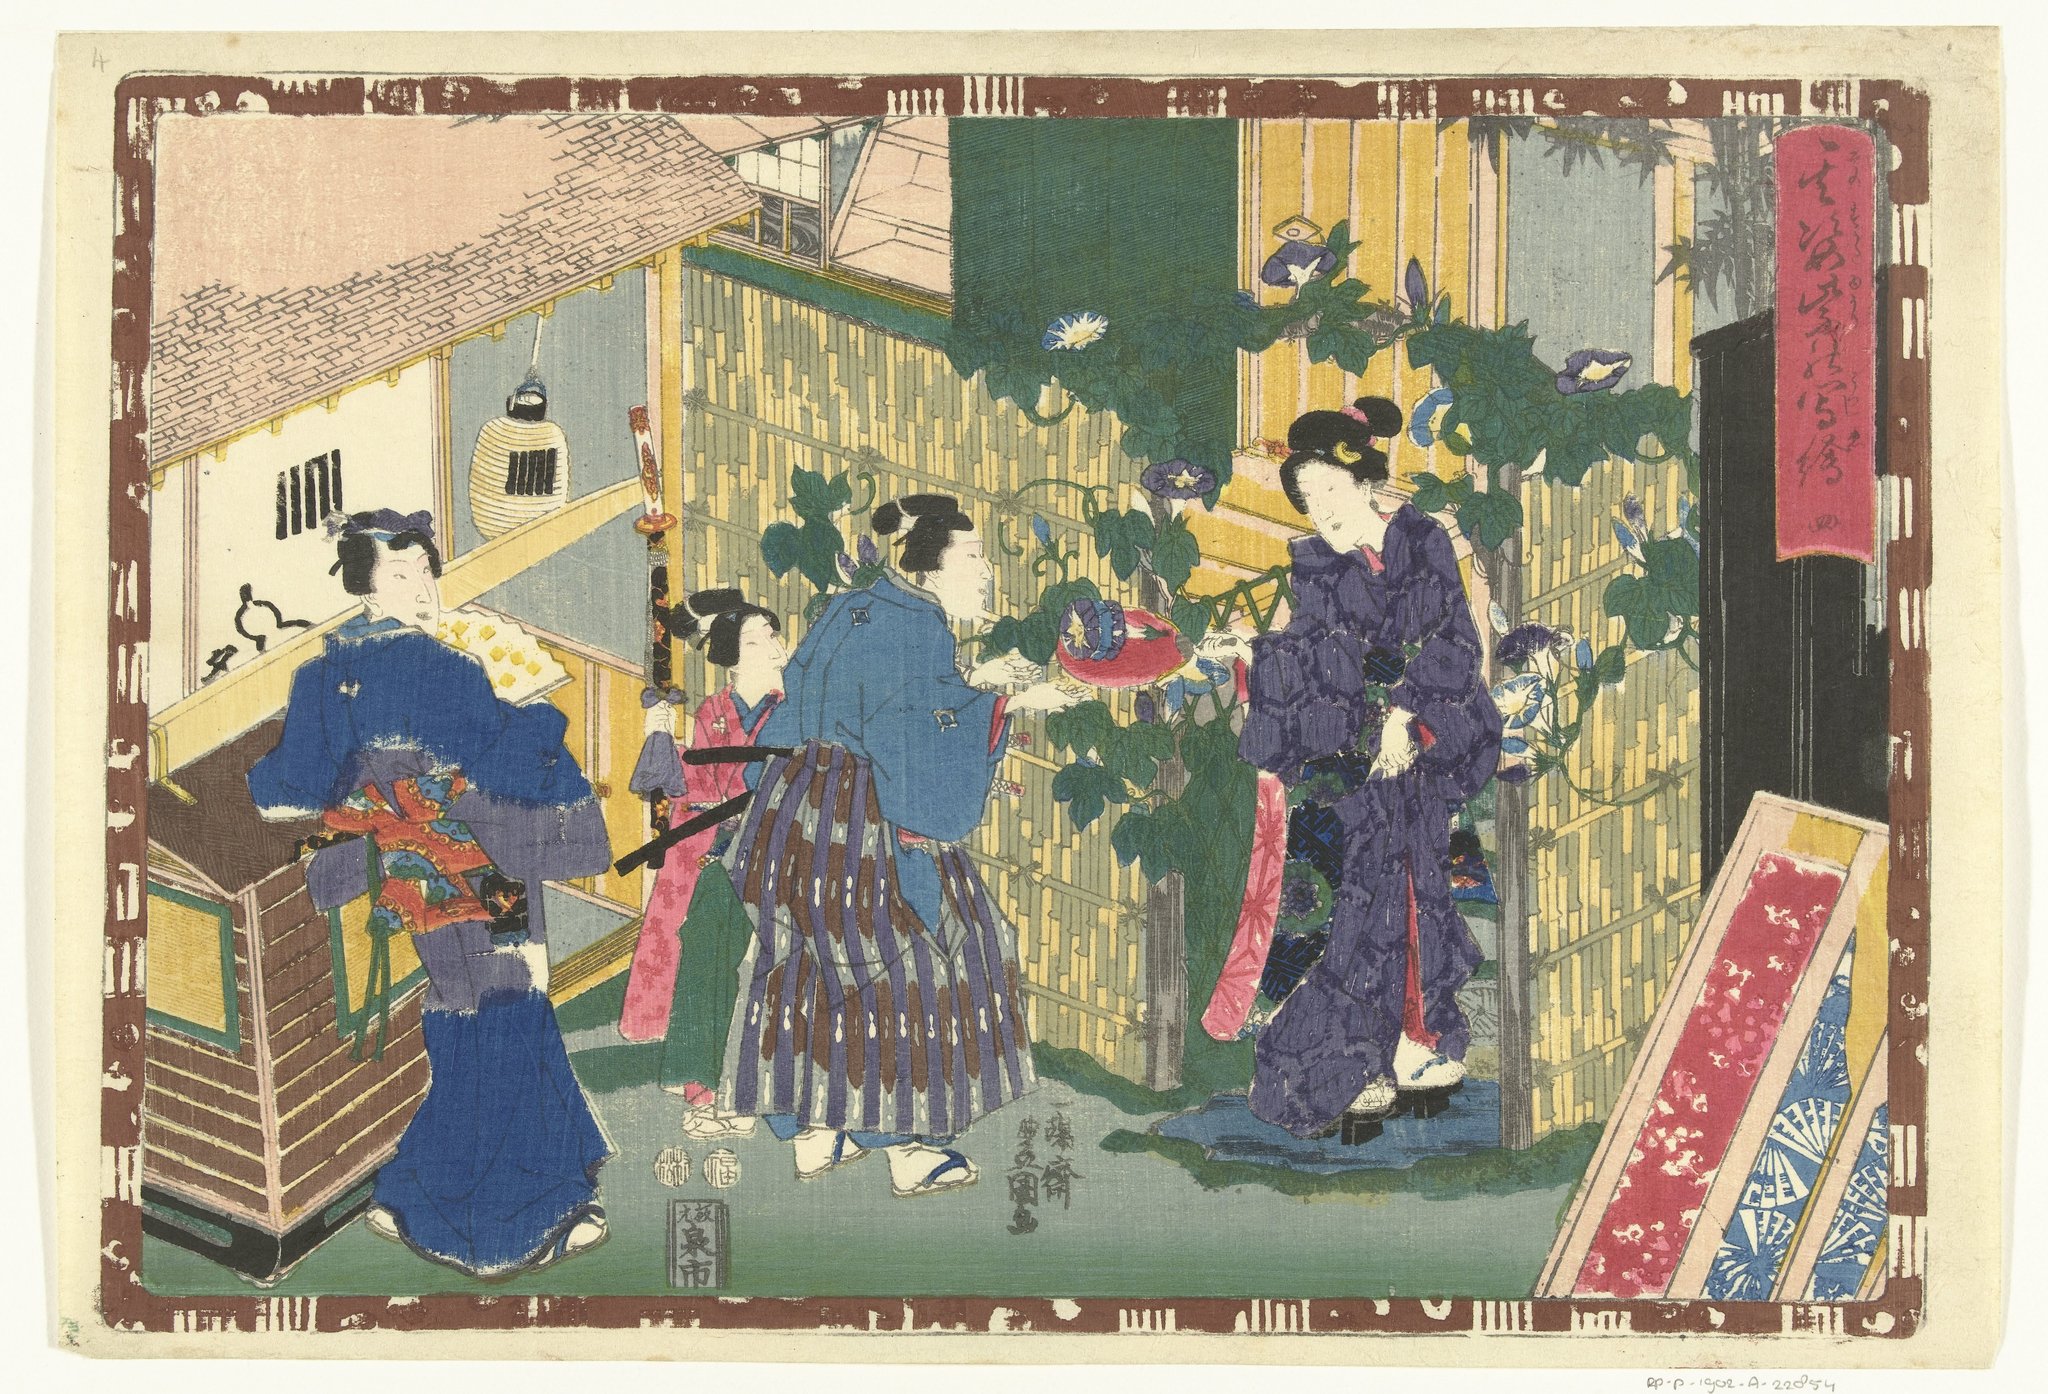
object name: print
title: Sono sugata Hikaru no utsushi-e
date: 1849-1853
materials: paper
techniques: woodcut, nishiki e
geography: tokyo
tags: garden, housing, house personnel, servants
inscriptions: collector's mark: Lugt 2228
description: Vrouw (Yugao) in paarse kimono, een waaier waarop een bloem aanbiedend aan dienstbode, bij tuinhek; prins Genji en dienstmeisje met zwaard toekijkend bij draagstoel.